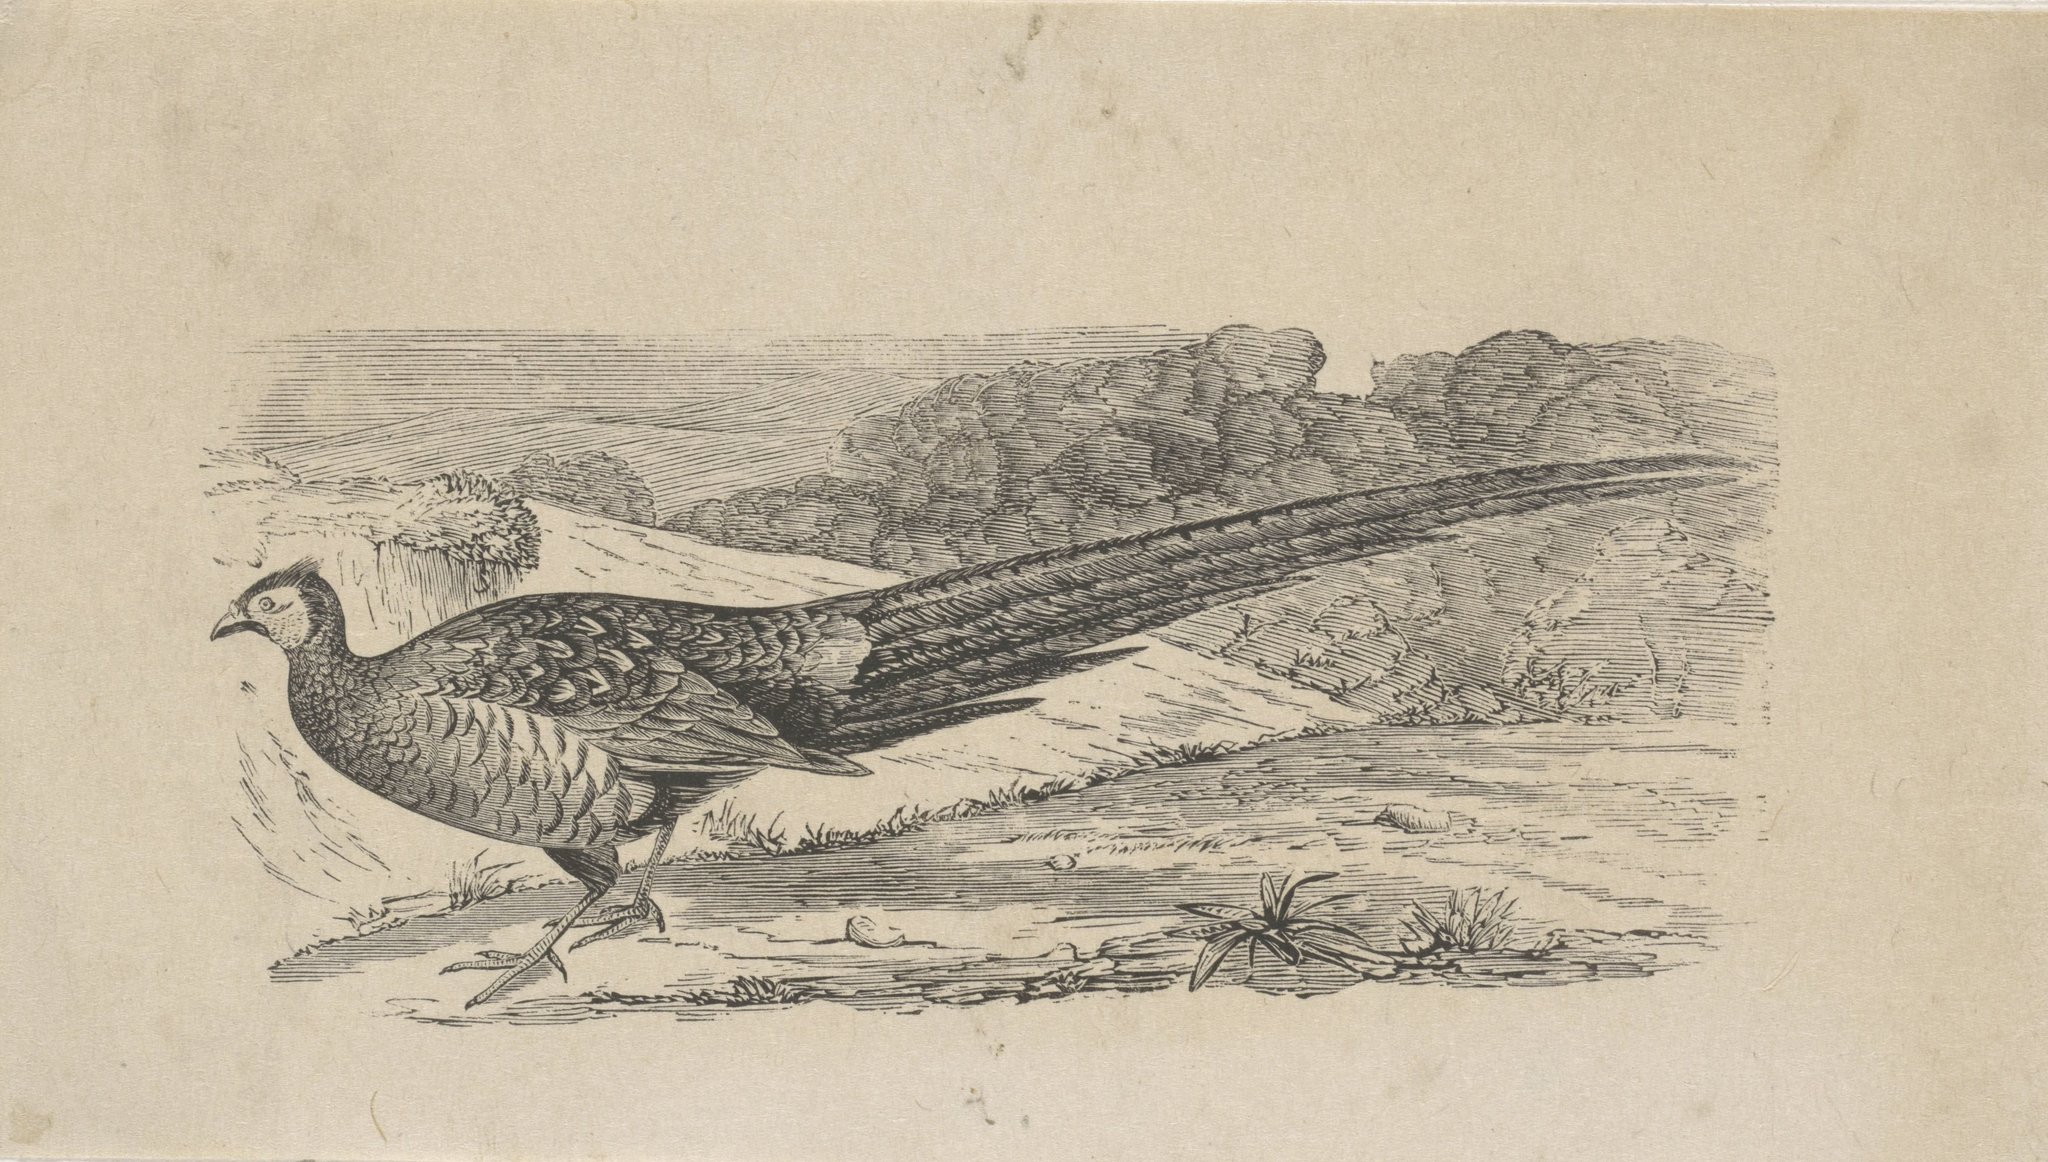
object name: print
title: Fazant in een heuvellandschap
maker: isaac weissenbruch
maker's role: print maker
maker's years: 1826-1912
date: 1836-1912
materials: paper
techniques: engraving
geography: netherlands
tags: low hill country, walker and runner birds: pheasant